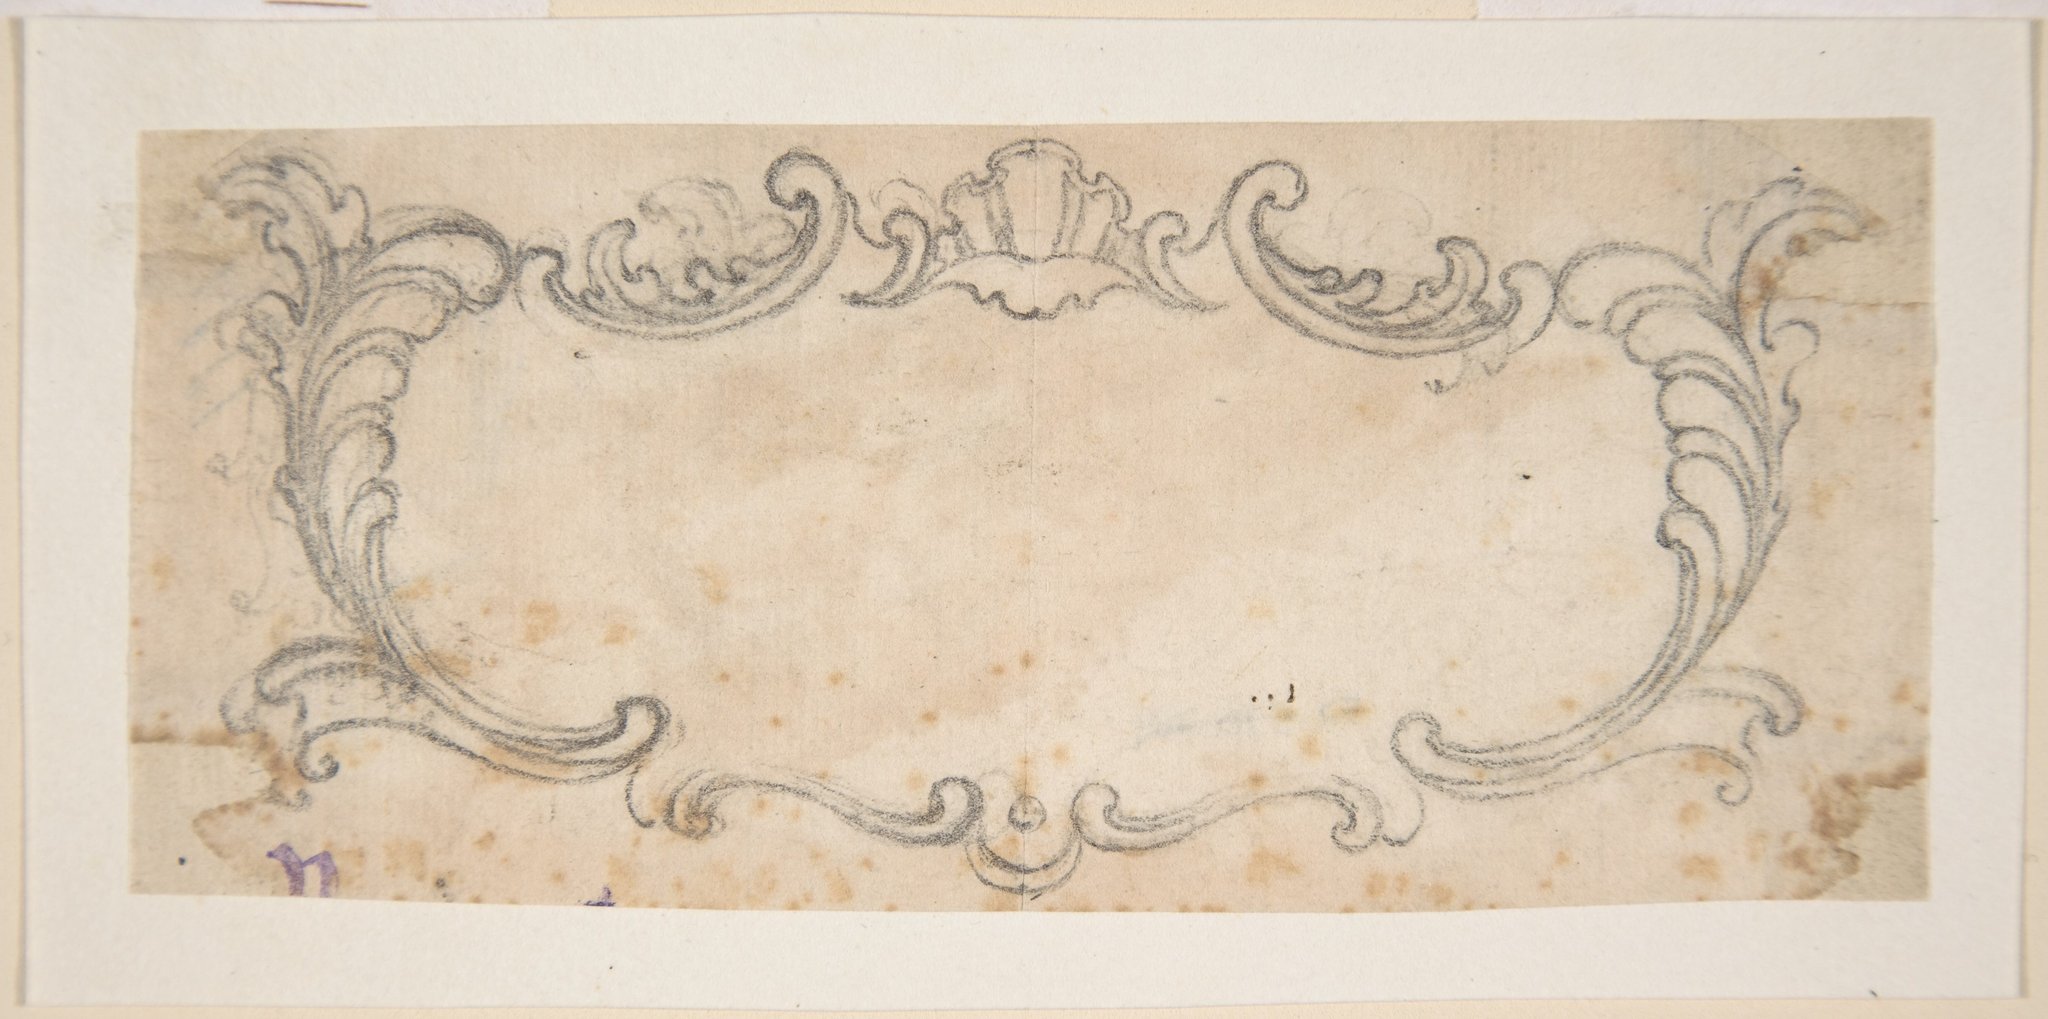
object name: drawing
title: Design for a Cartouche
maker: giovanni battista foggini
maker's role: artist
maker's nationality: italian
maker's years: 1652-1725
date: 1672-1725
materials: chalk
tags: cartouches